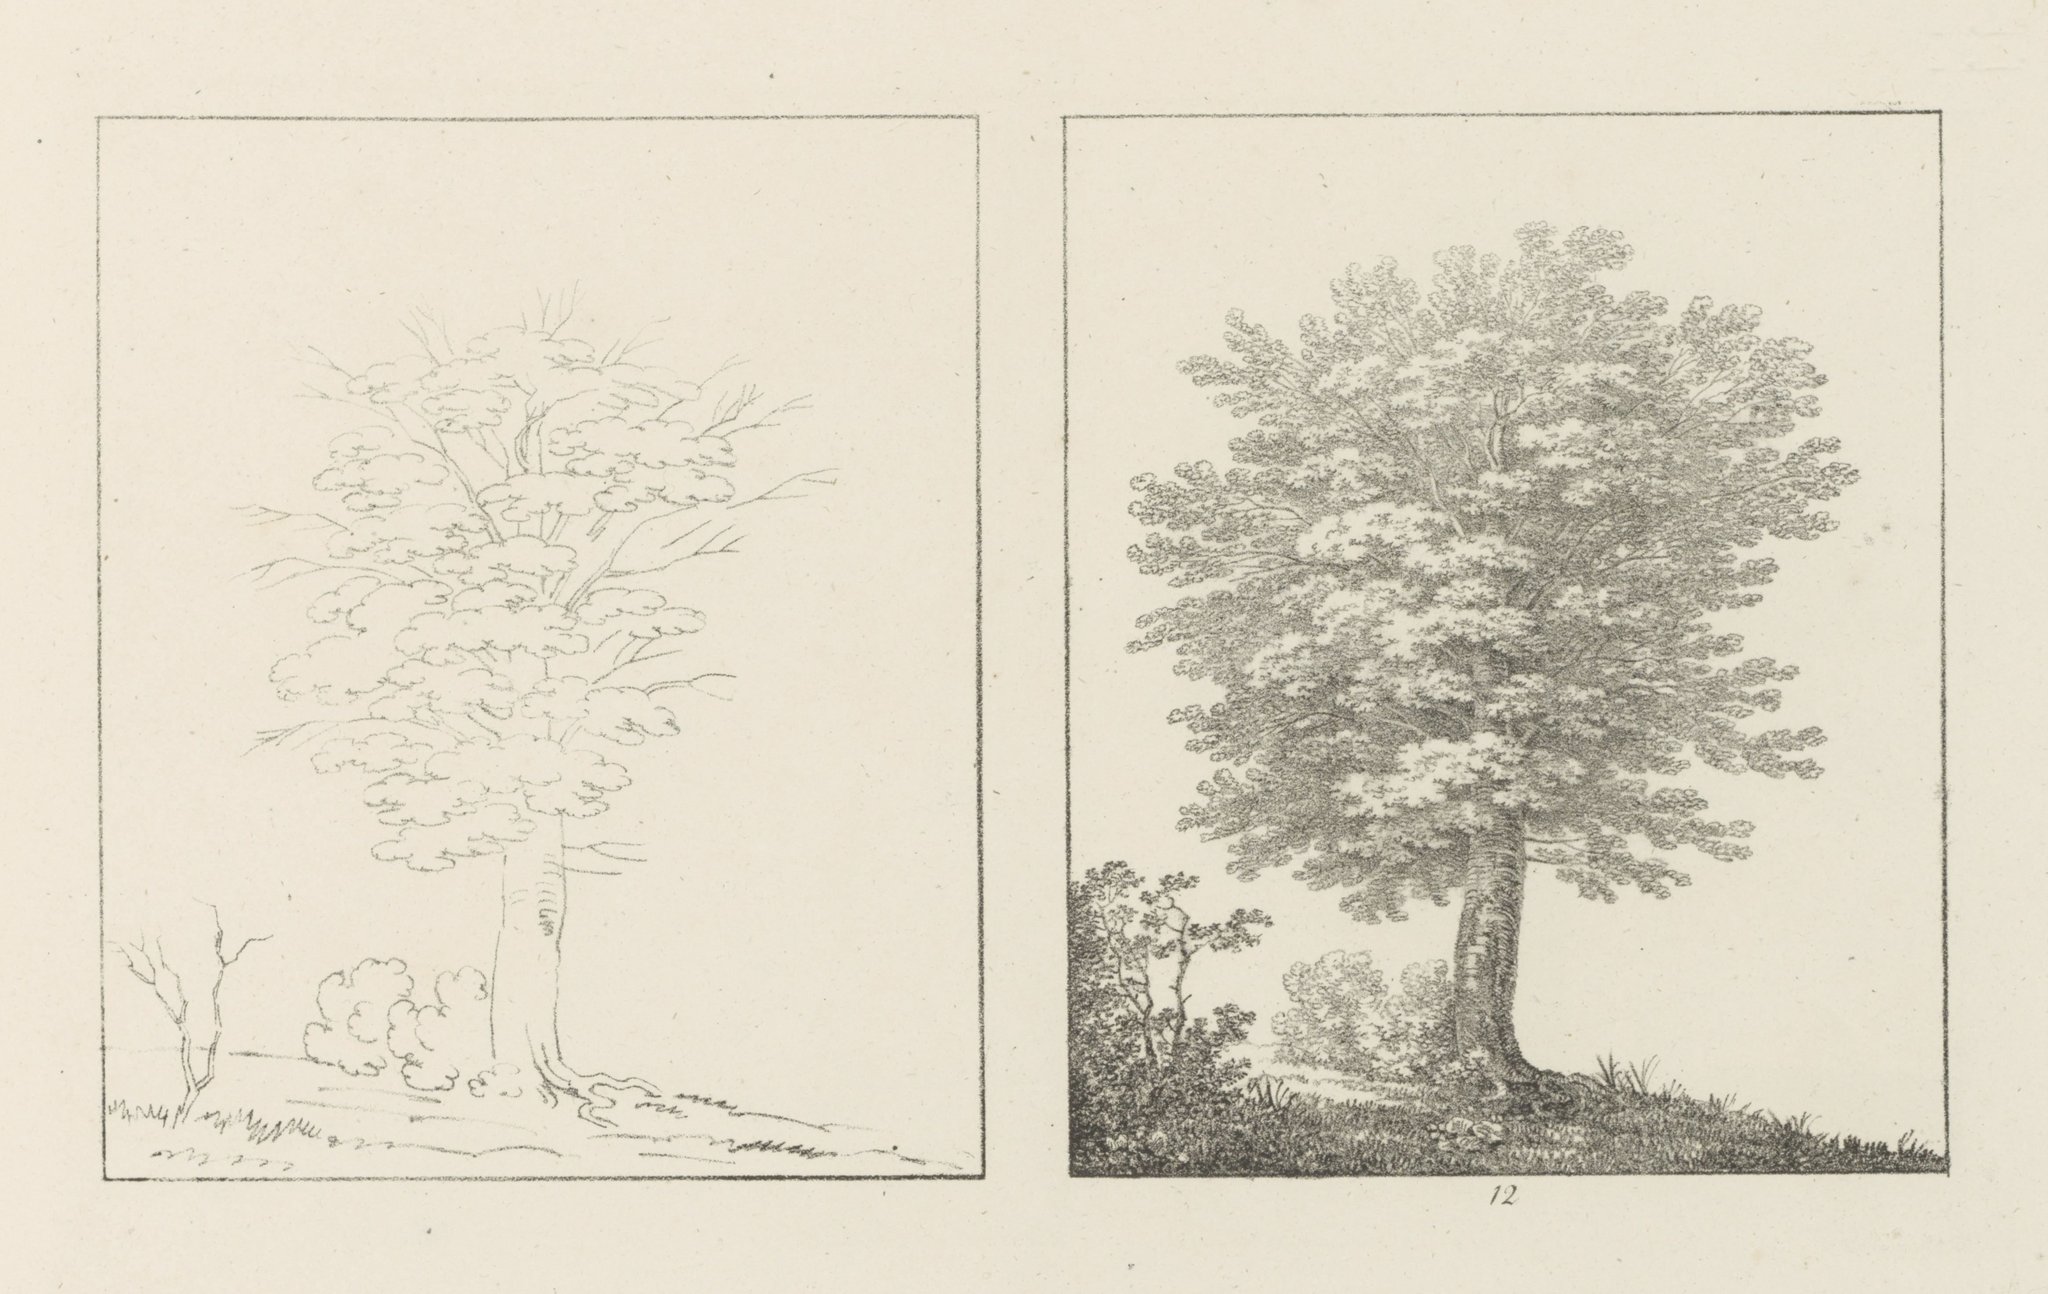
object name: print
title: Albumblad met twee voorstellingen van twee beukenbomen: links het ontwerp, rechts de uitvoering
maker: max josef wagenbauer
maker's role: print maker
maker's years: 1774-1829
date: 1816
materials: paper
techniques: lithograph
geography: munich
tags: trees, the graphic arts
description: Albumblad met twee voorstellingen van twee beukenbomen: links het ontwerp, rechts de uitvoering. Maakt deel uit van een album met 18 bladen met studies van bomen.